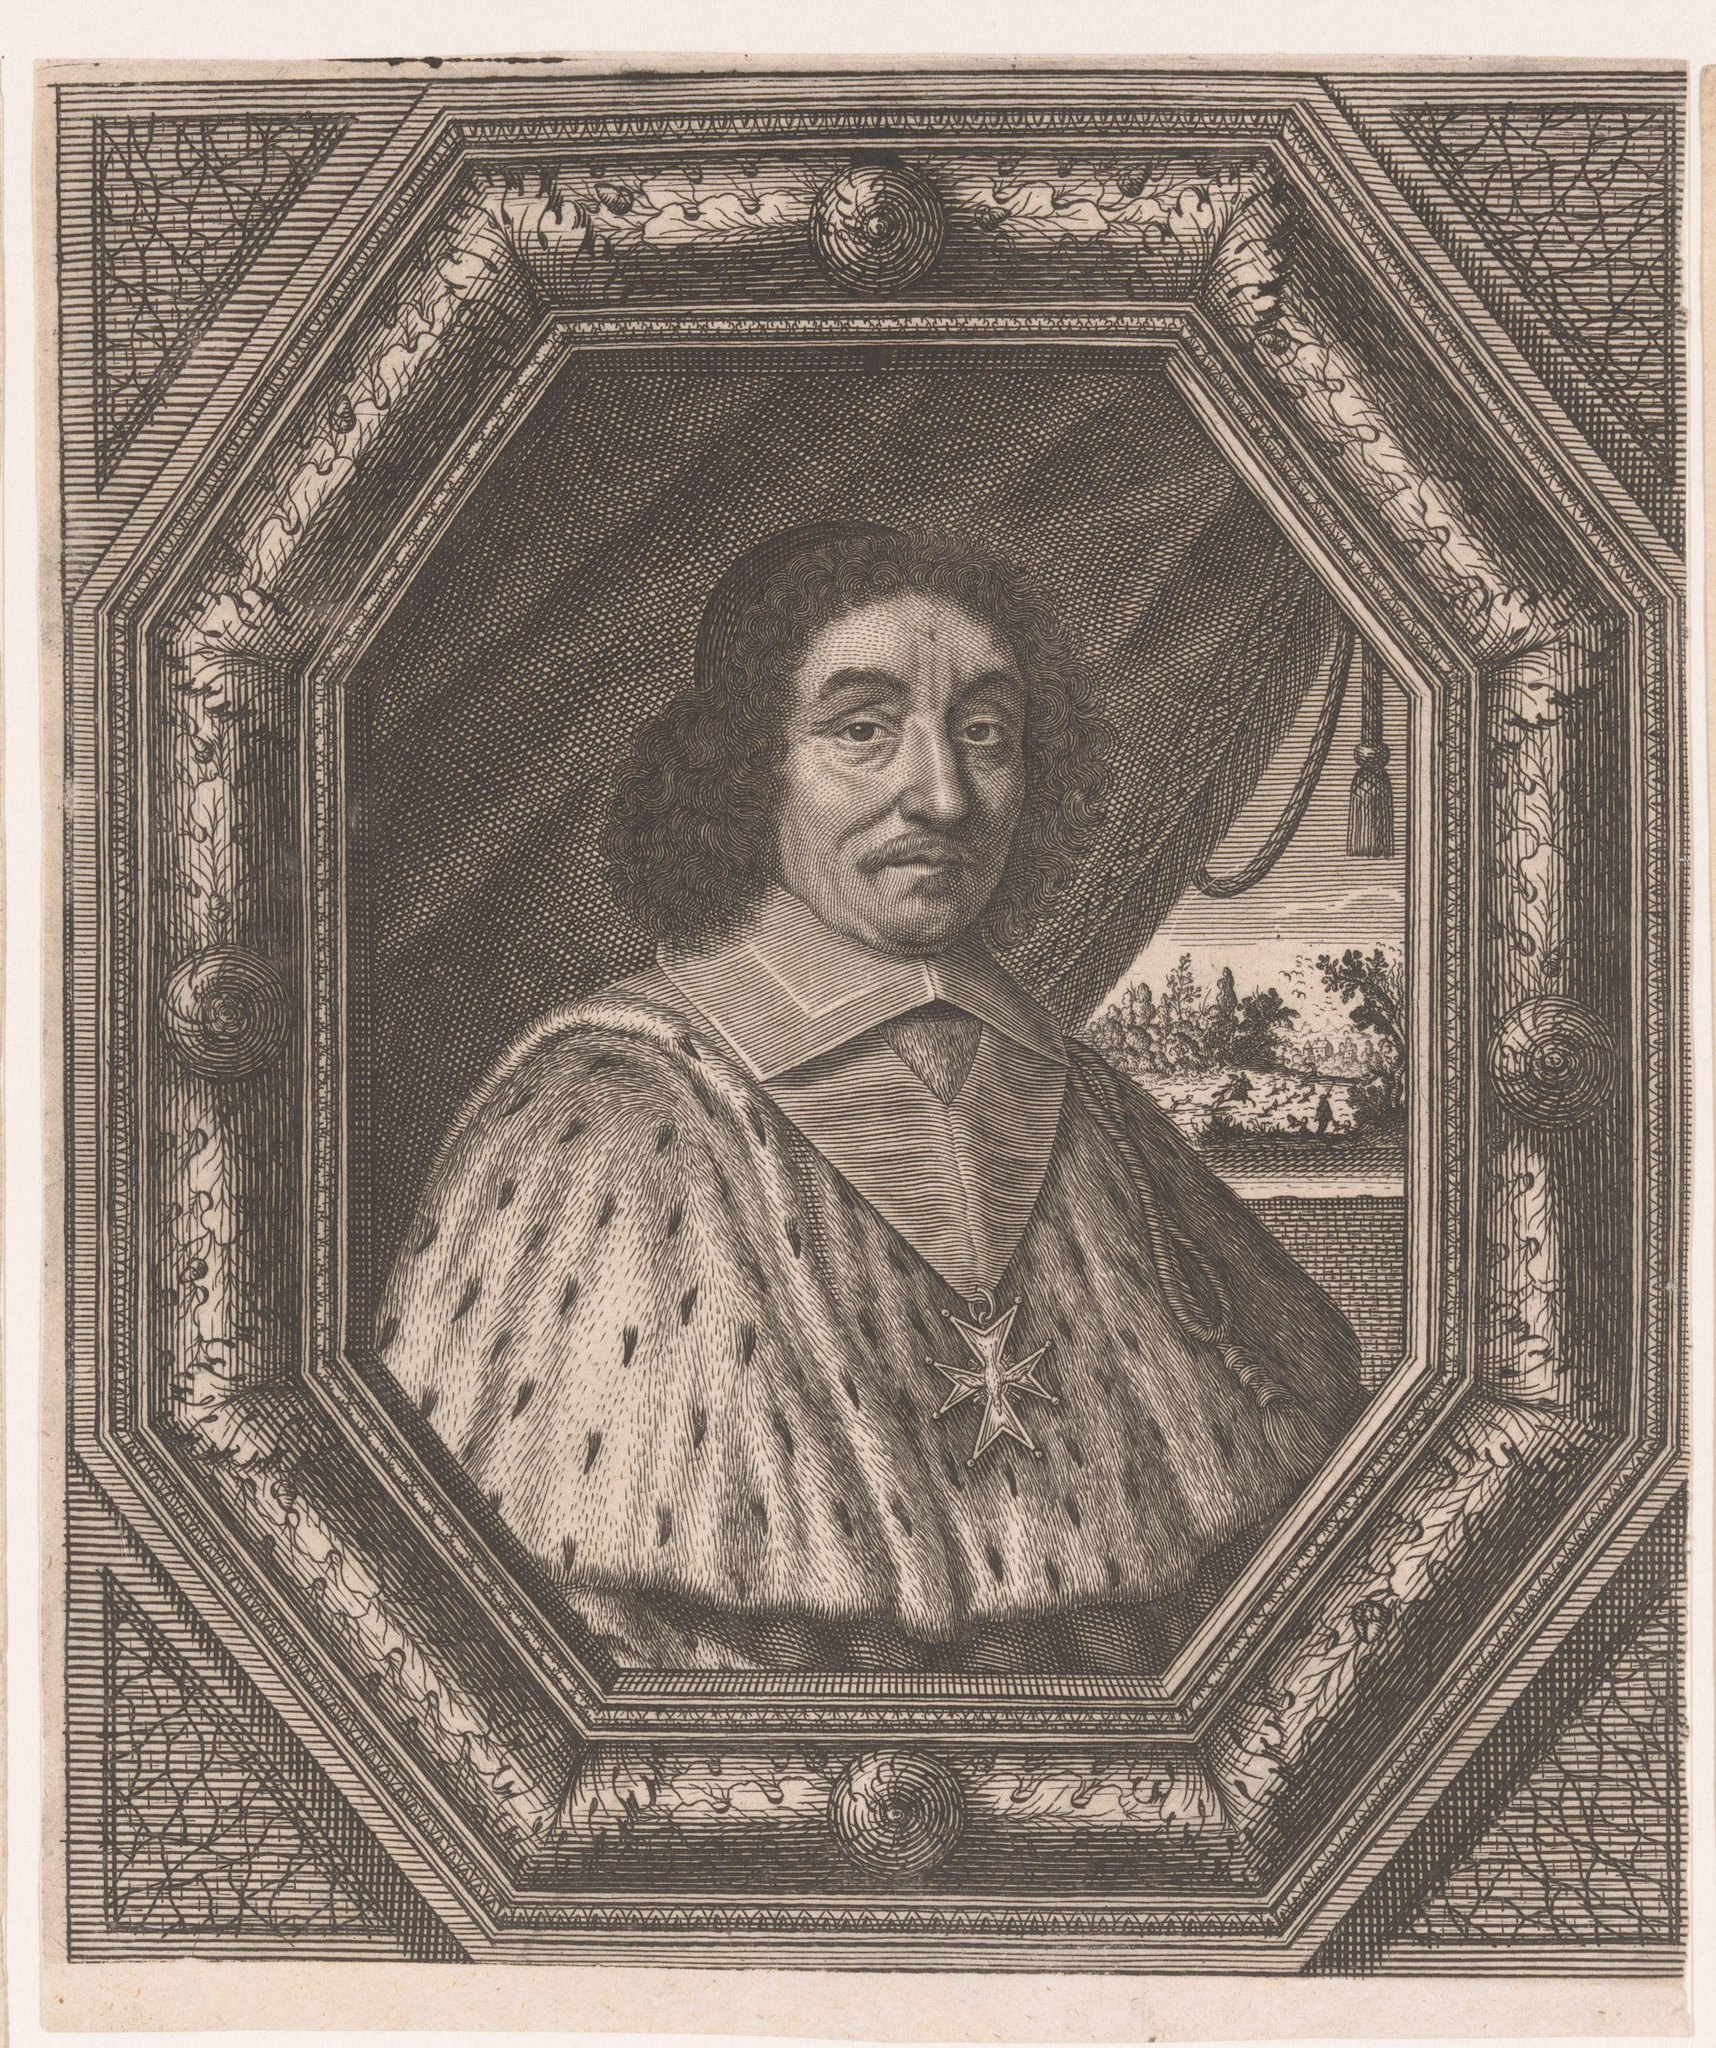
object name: print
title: Portret van Pierre Séguier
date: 1651-1668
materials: paper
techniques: engraving, etching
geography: paris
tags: paris, pierre séguier, historical persons, politician, e.g. party leader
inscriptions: collector's mark: Lugt 2228